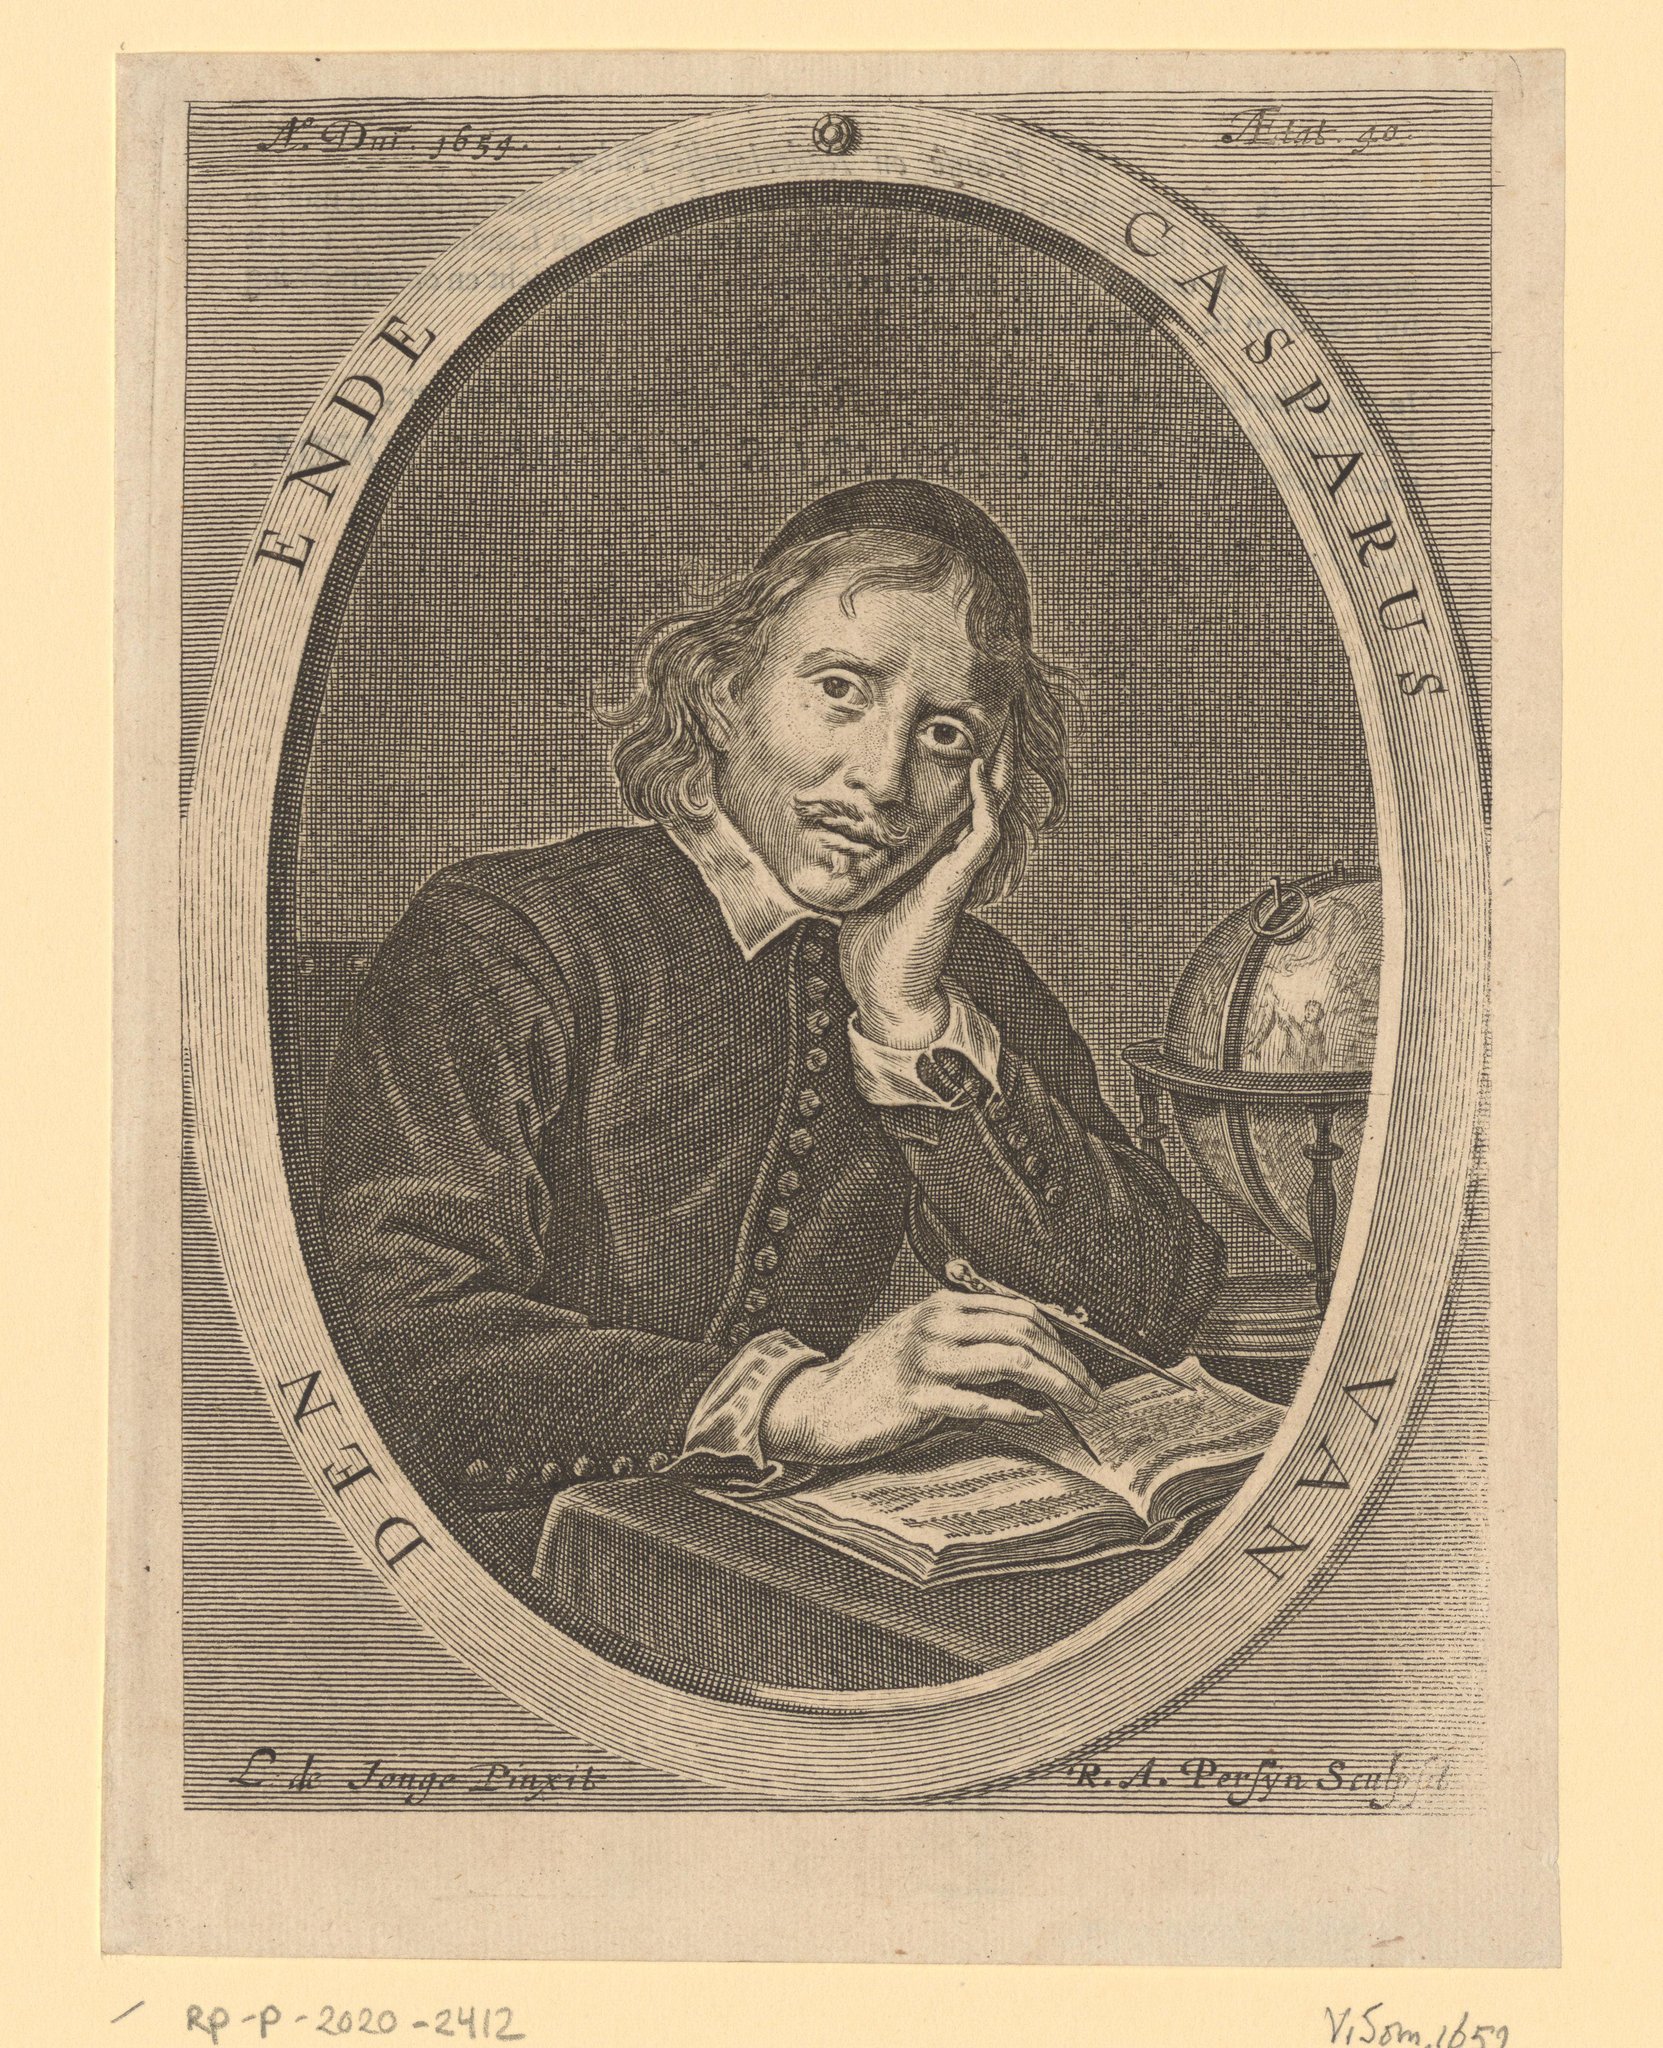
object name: print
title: Portret van Caspar van den Ende op 40-jarige leeftijd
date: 1654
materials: paper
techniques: engraving, letterpress printing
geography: rotterdam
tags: amsterdam, historical persons, compasses, globe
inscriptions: inscription: ‘ook 1699 4° [...] Abkoude’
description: Prent uit: Ende, Caspar van den. Le gazophilace de la langue francoise et flamande (...). Rotterdam: Isaac Naeranus, 1681. Prent met andere tekst op verso gebruikt in edities van het werk uit 1669 en 1697.